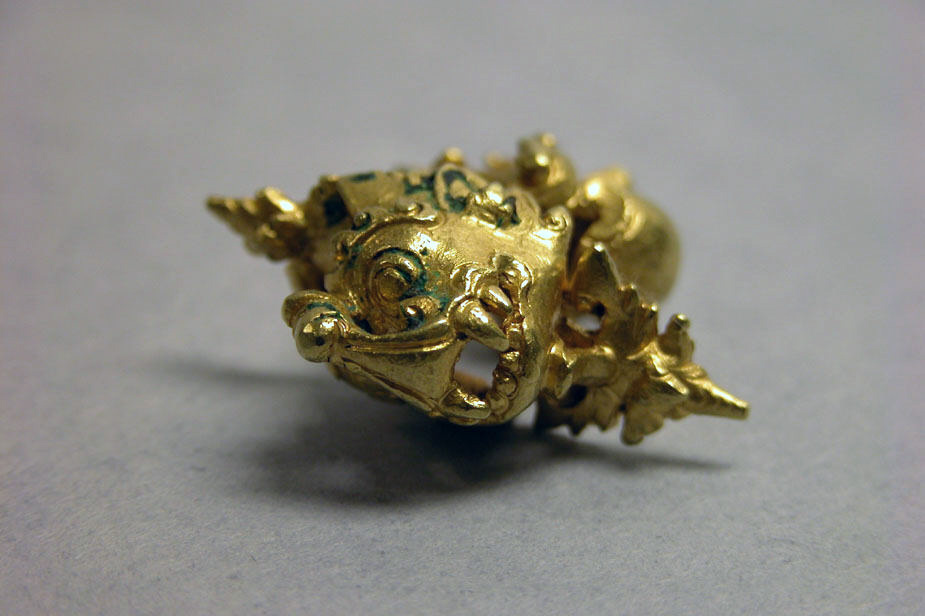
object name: ear ornament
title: Ear Ornament with Makara Motif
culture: indonesian, javanese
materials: gold